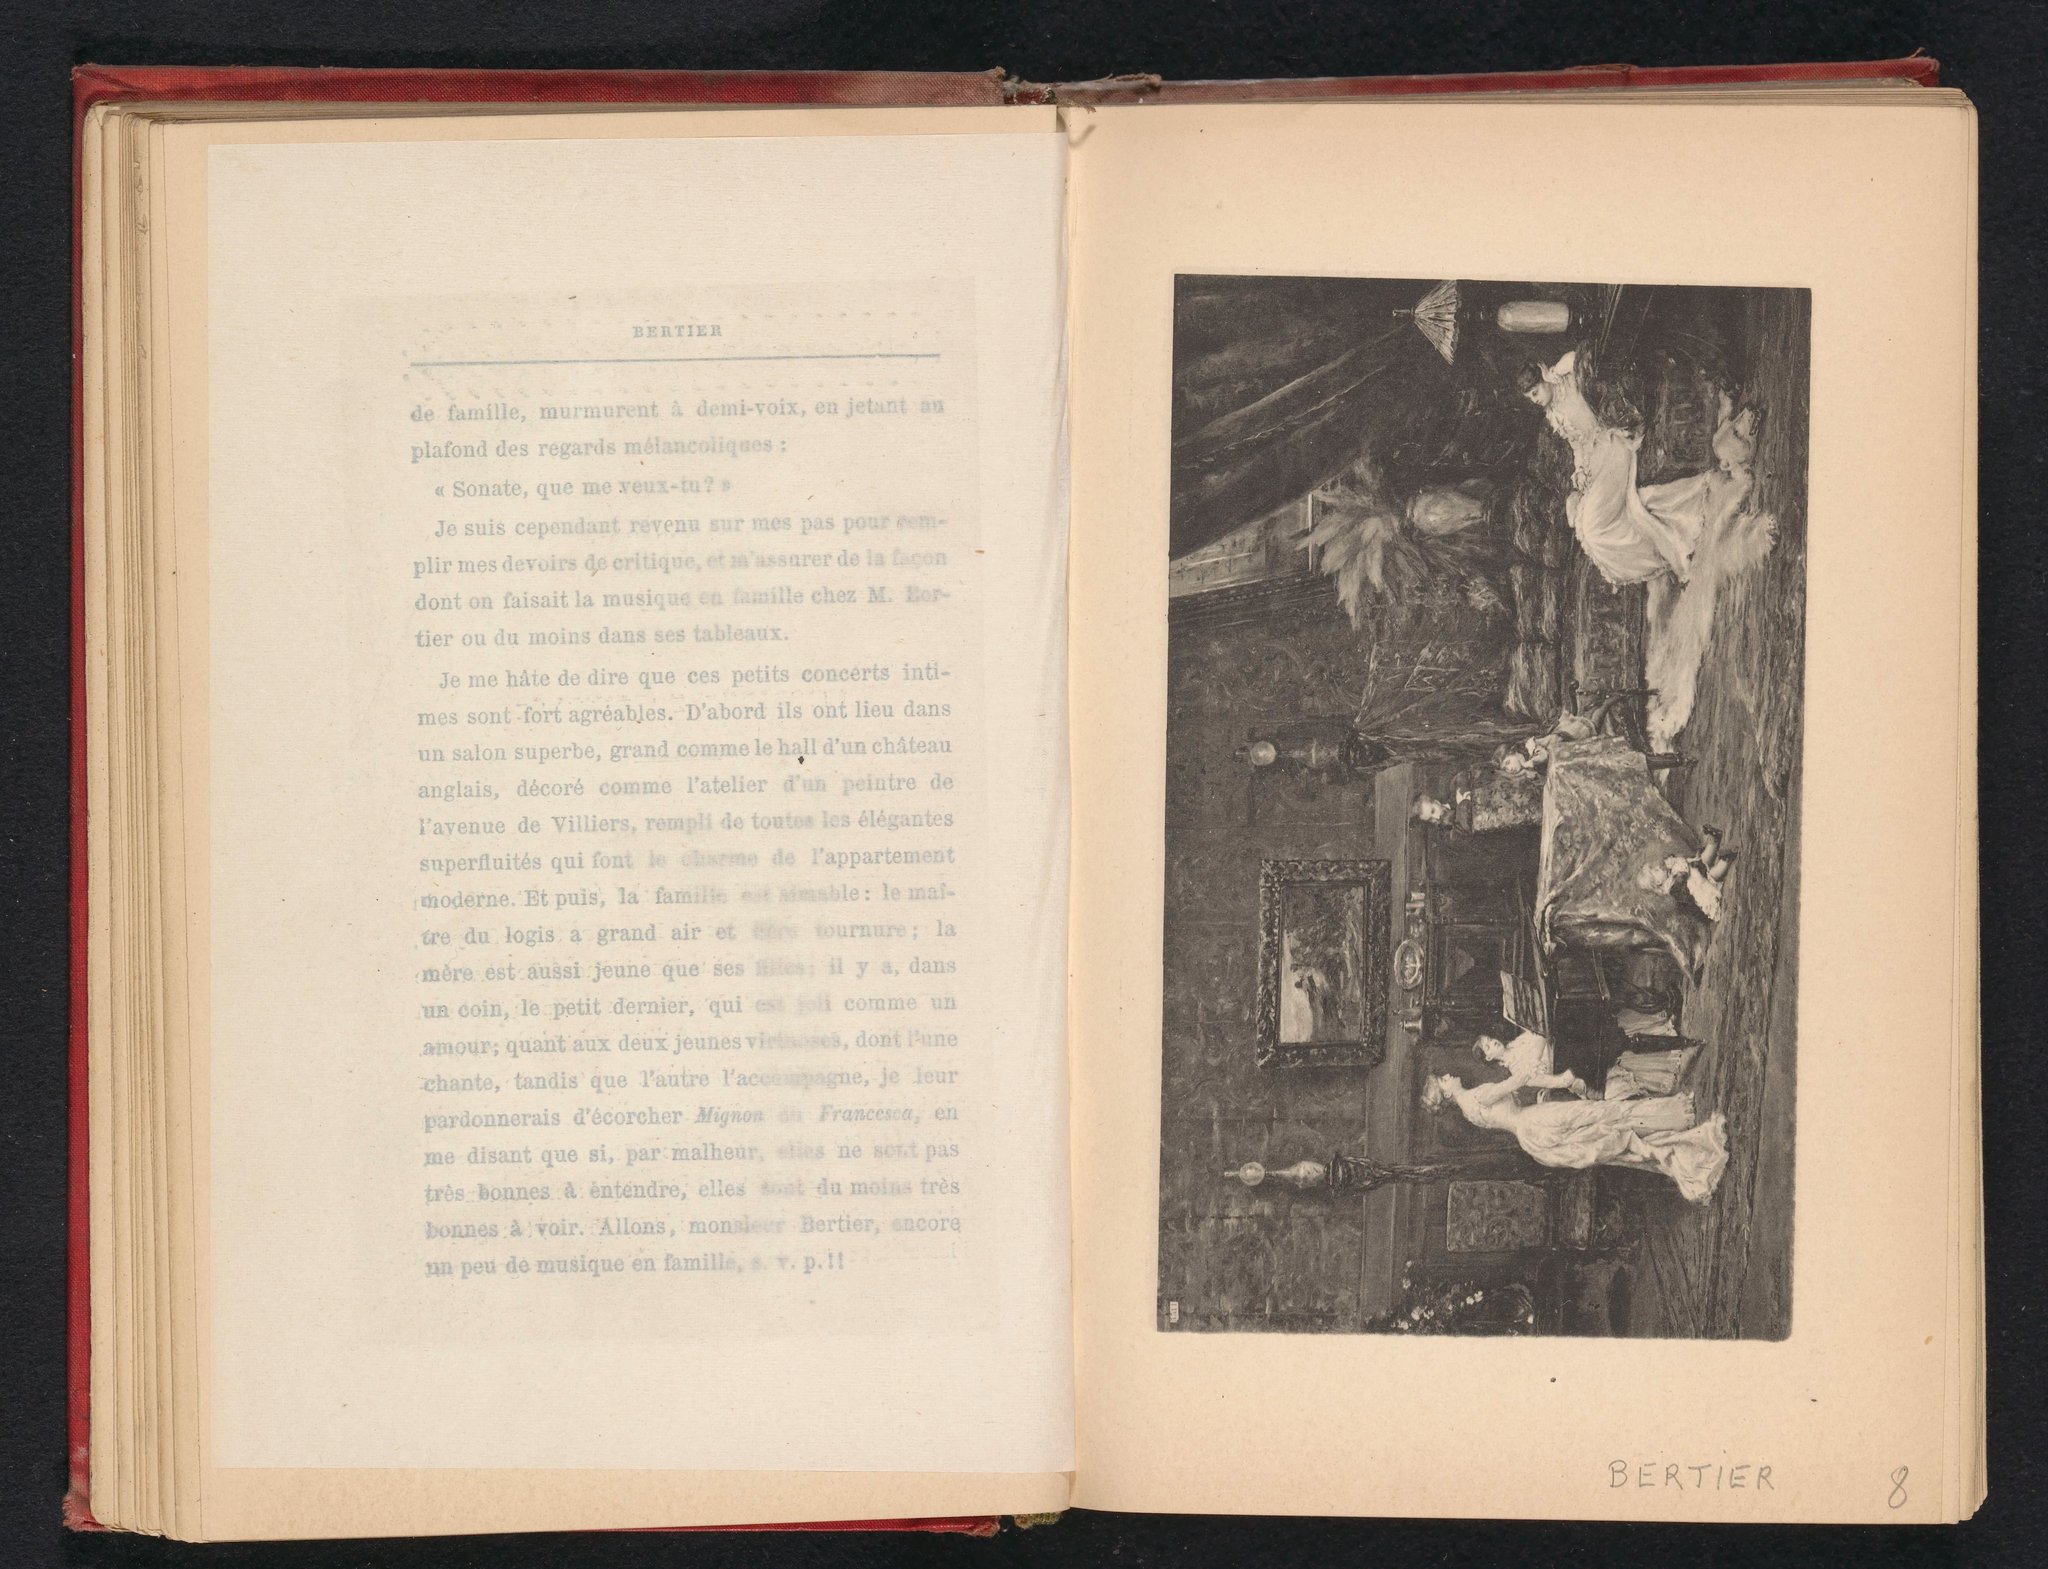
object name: page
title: Fotoreproductie van een schilderij, voorstellende twee vrouwen achter een piano in een interieur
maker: charles bertier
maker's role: painter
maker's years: 1860-1924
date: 1872-1882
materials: paper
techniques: photograph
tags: one person playing keyboard instrument, grand piano, sculpture (+ relief ~ sculpture)